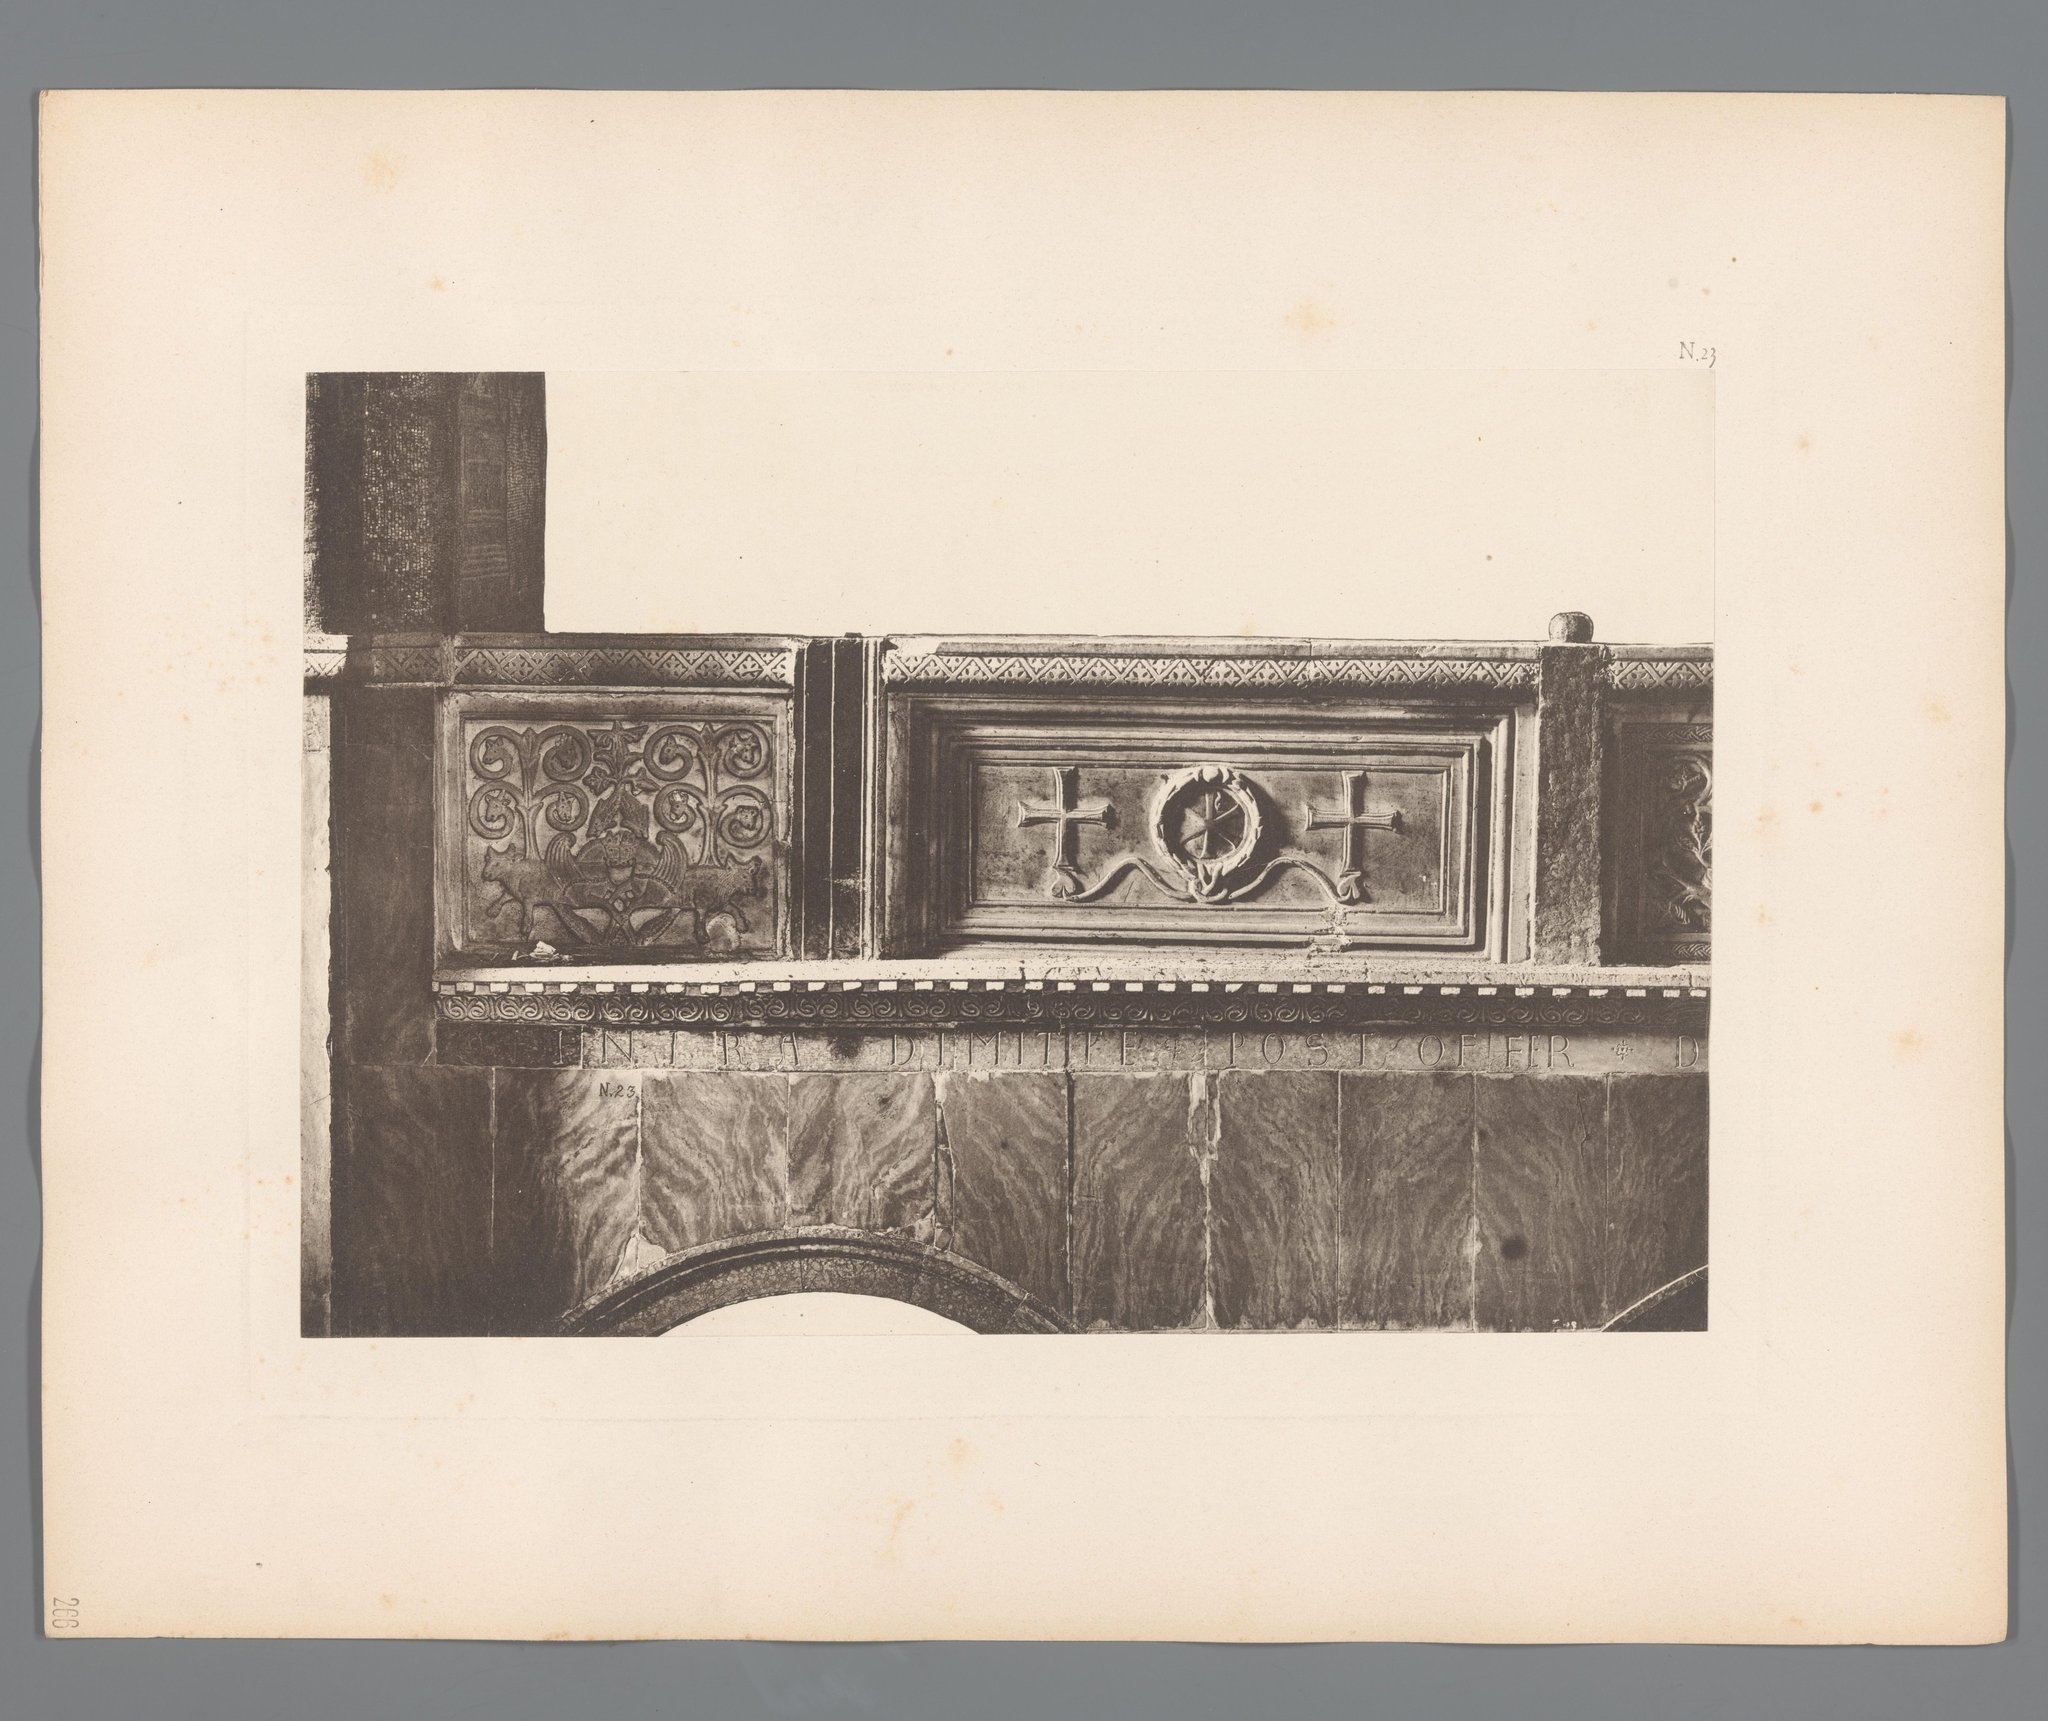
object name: photomechanical print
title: Balustrade met reliëf van de San Marco in Venetië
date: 1880-1885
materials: paper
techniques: photograph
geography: venice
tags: balustrade, piece of sculpture, reproduction of a piece of sculpture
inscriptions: number: ‘N.23’, number: ‘266’, number: ‘N.23.’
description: Deze prent maakt deel uit van een omslag met 58 prenten op 50 bladen.